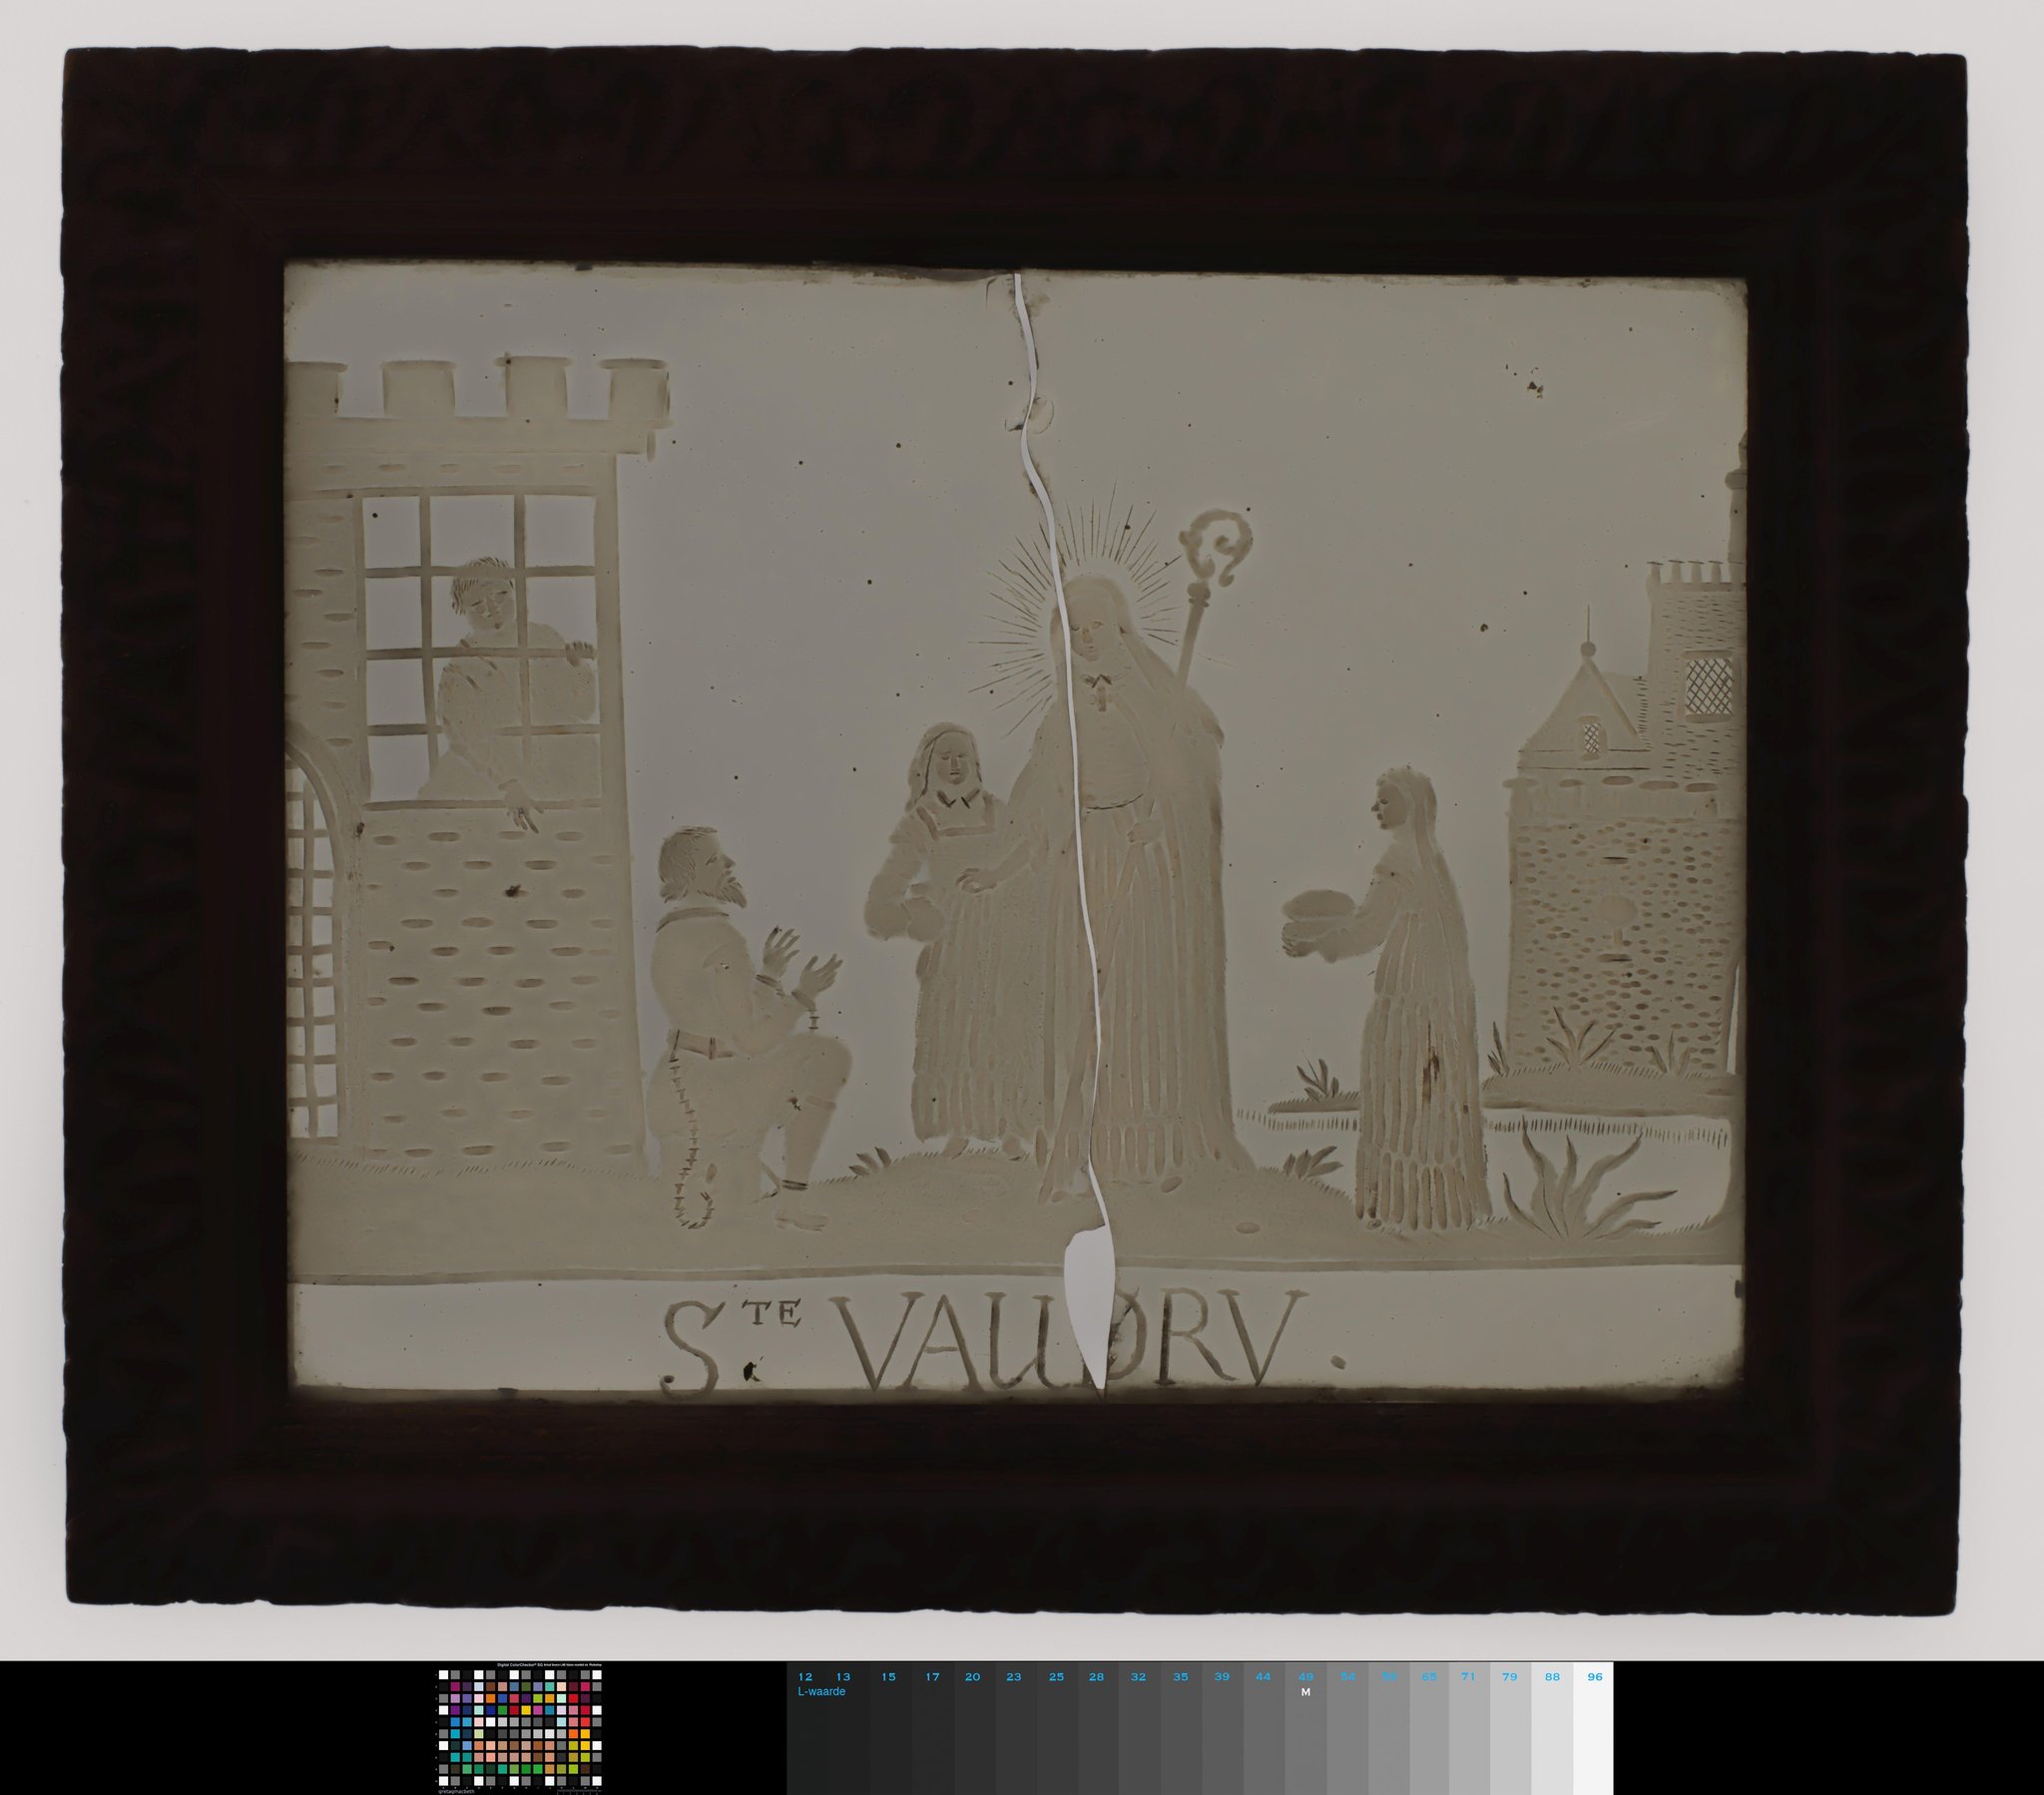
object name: sheet glass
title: Glasplaat waarin geslepen St. Vandry, die voedsel brengt aan gevangenen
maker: Anonymous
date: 1675-1700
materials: glass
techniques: gilding, grinding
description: Glasplaat waarin geslepen St. Vandry, diie voedsel brengt aan gevangenen. In vergulde lijst. In tweeën gebroken.